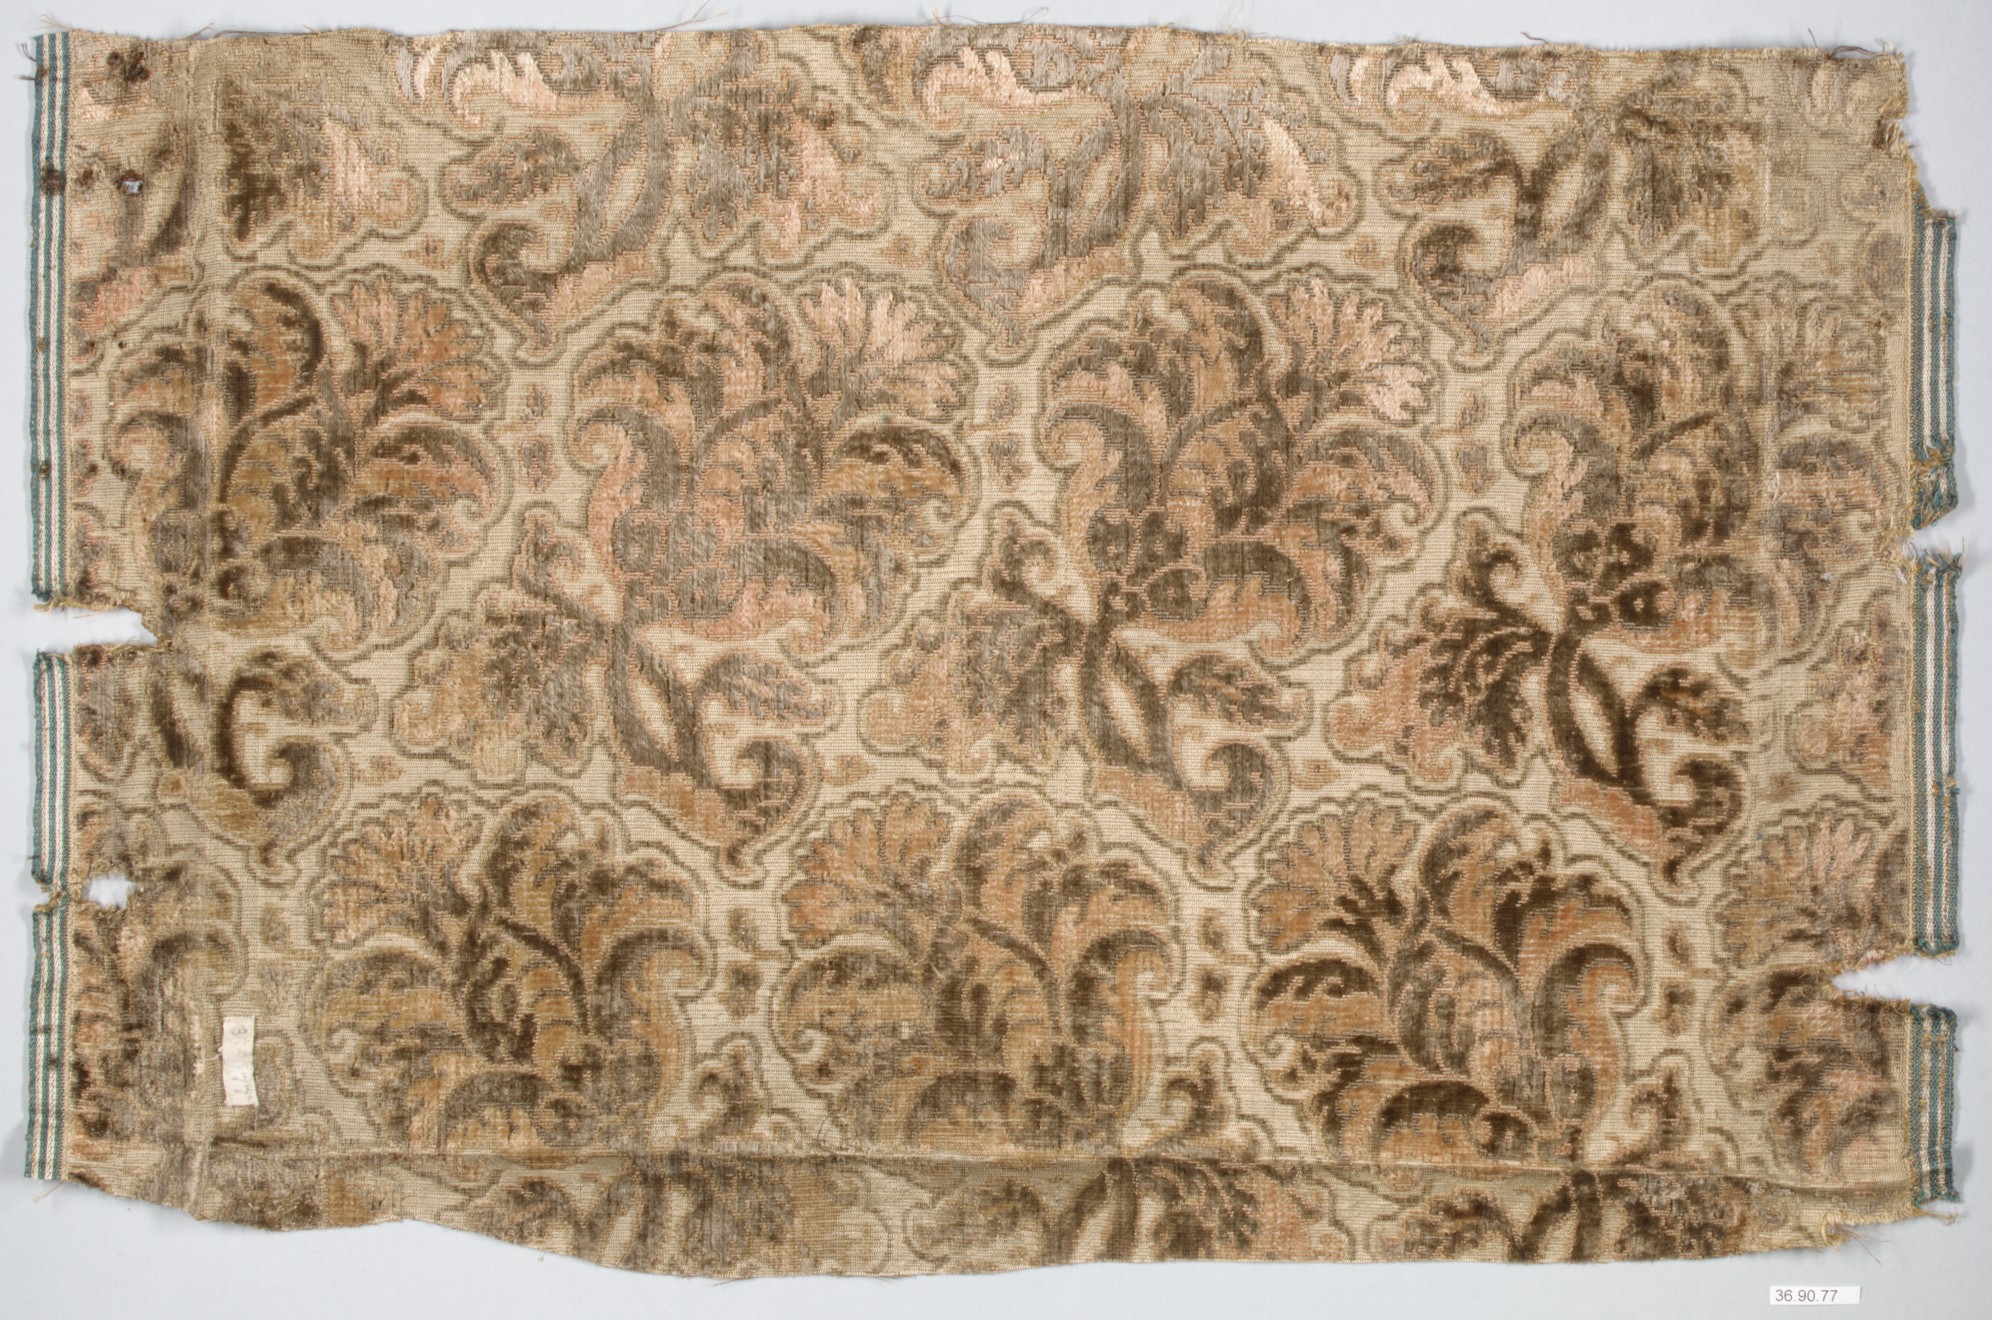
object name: piece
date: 1501-1700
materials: metal thread, silk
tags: flowers